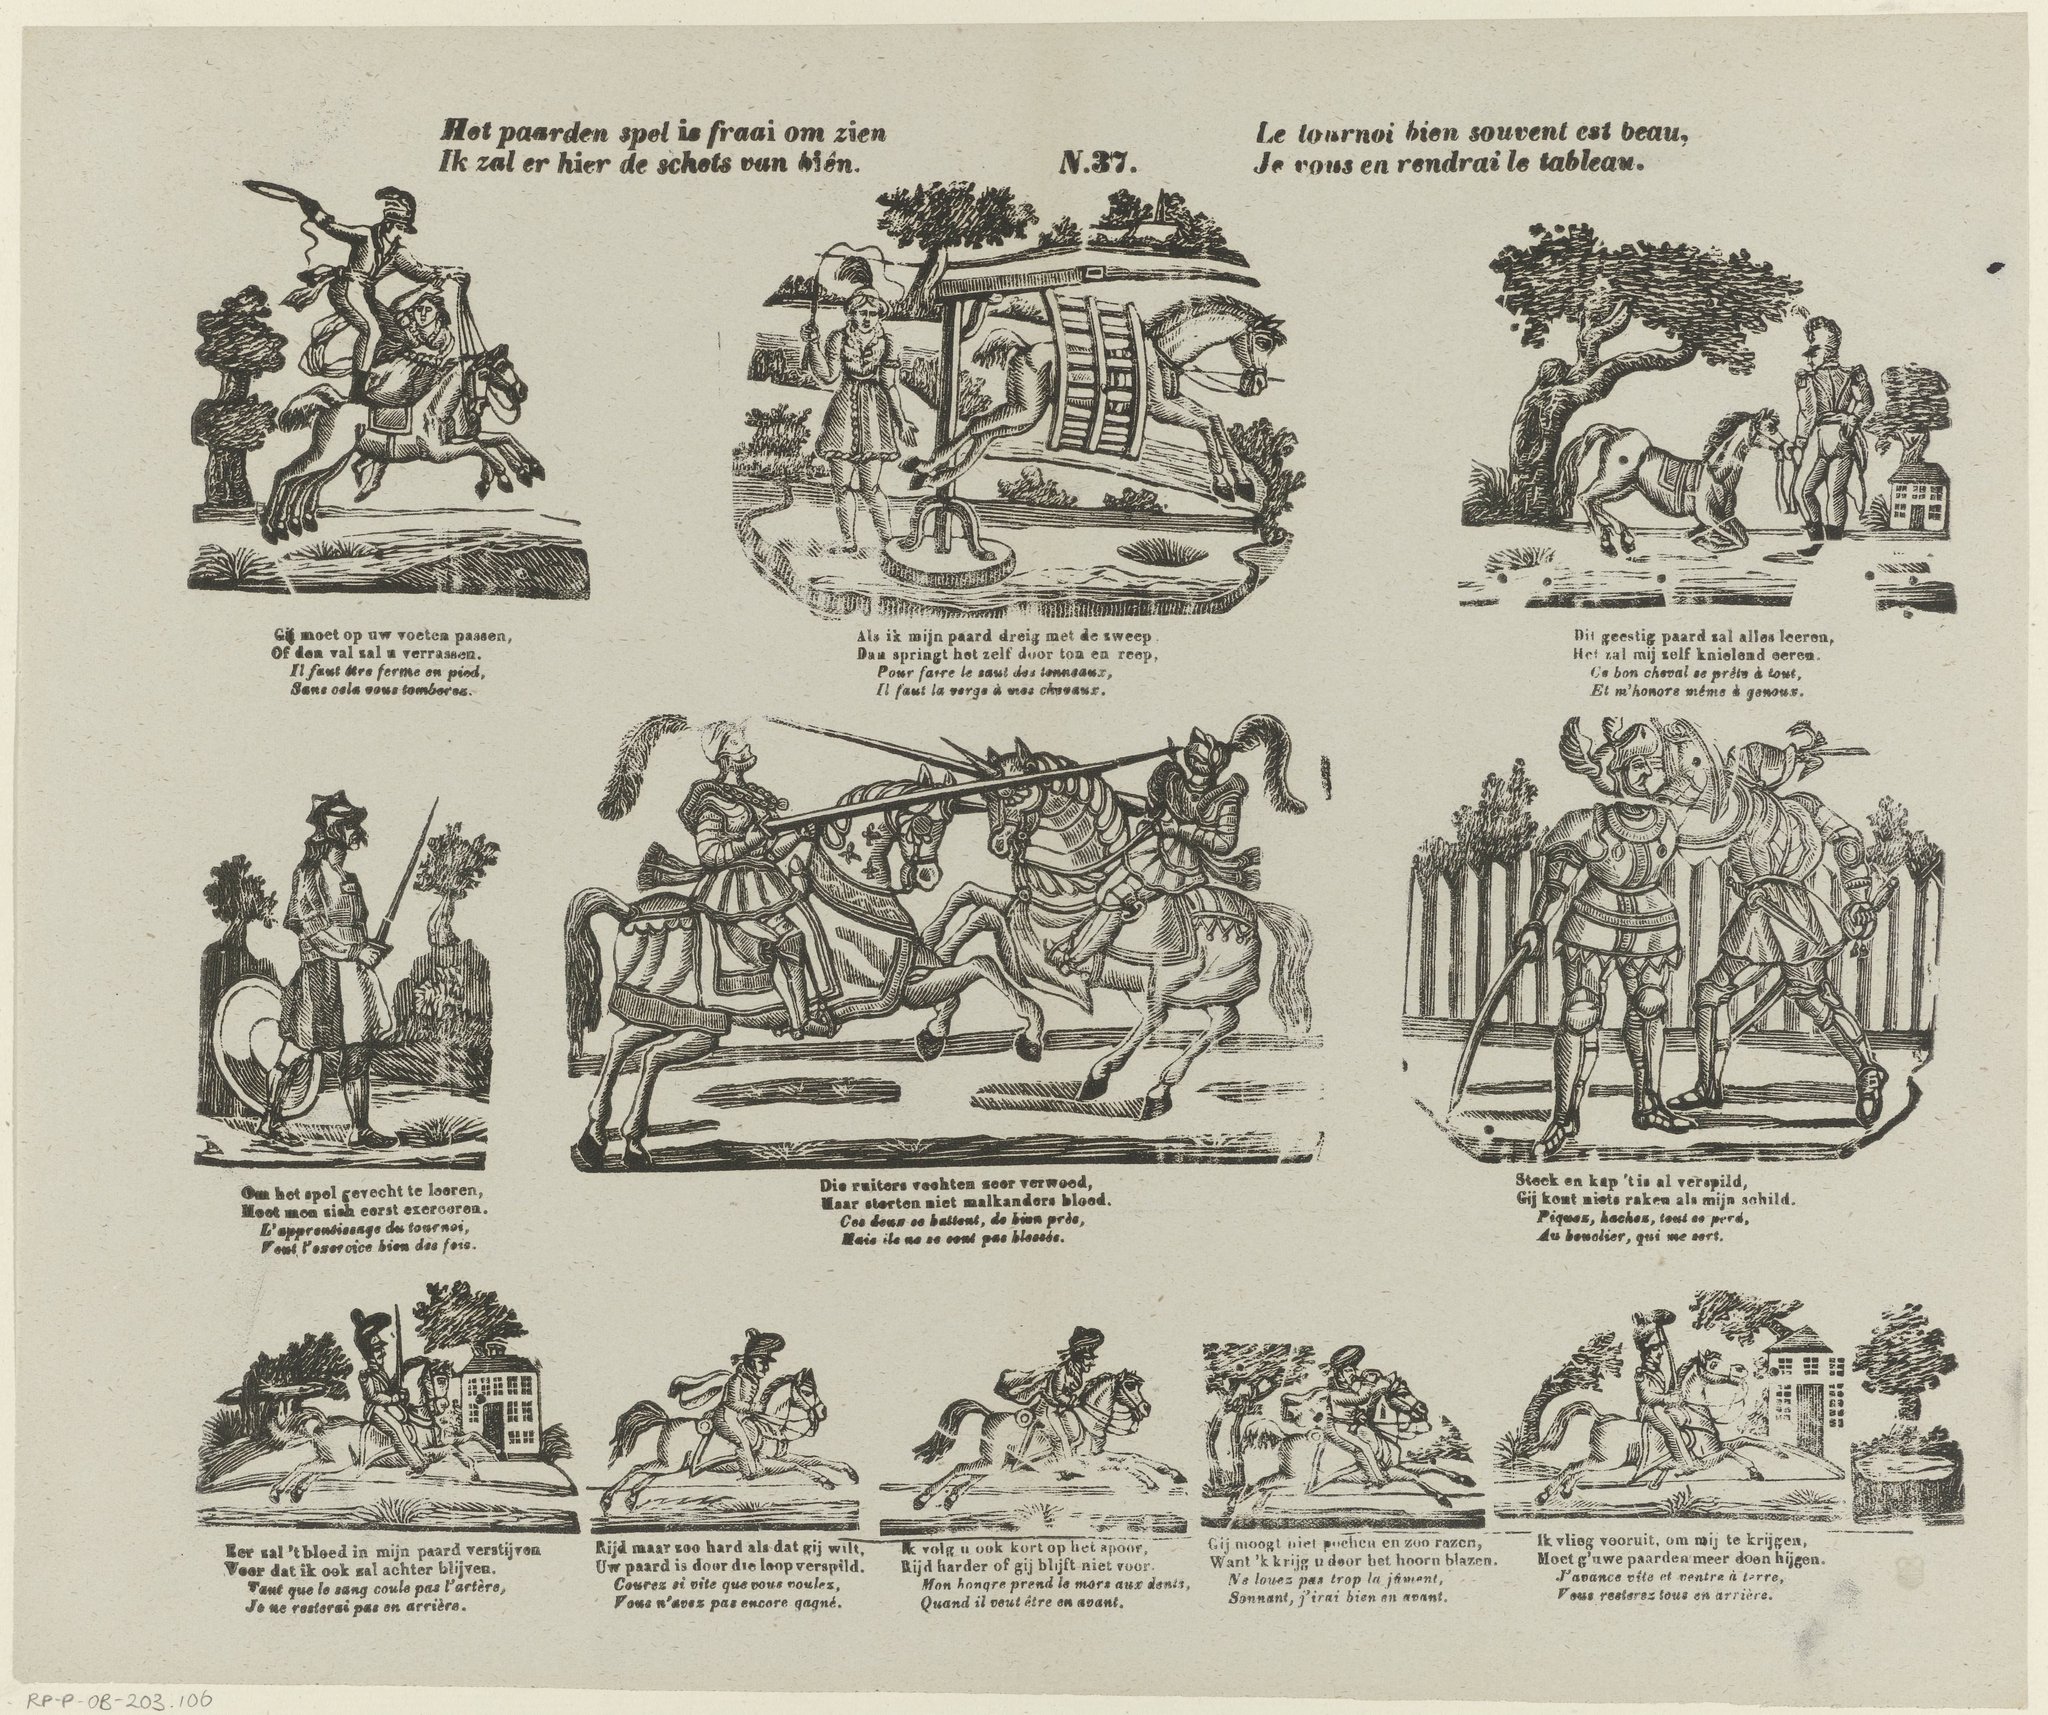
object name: print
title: Het paarden spel is fraai om zien, / Ik zal er hier de schets van biên / Le tournoi bien souvent est beau, / Je vous en rendrai le tableau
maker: Anonymous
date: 1833-1900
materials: paper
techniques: letterpress printing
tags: riding a horse, ass, or mule; rider, horseman, warfare; military affairs (+ cavalry, horsemen), horses (circus performance)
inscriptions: collector's mark: Lugt 2760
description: Blad met 12 voorstellingen van curcusartiesten, ruiters en militairen met paarden. Onder elke voorstelling een tweeregelig vers in het Nederlands en in het Frans. Genummerd midden boven: N. 37.